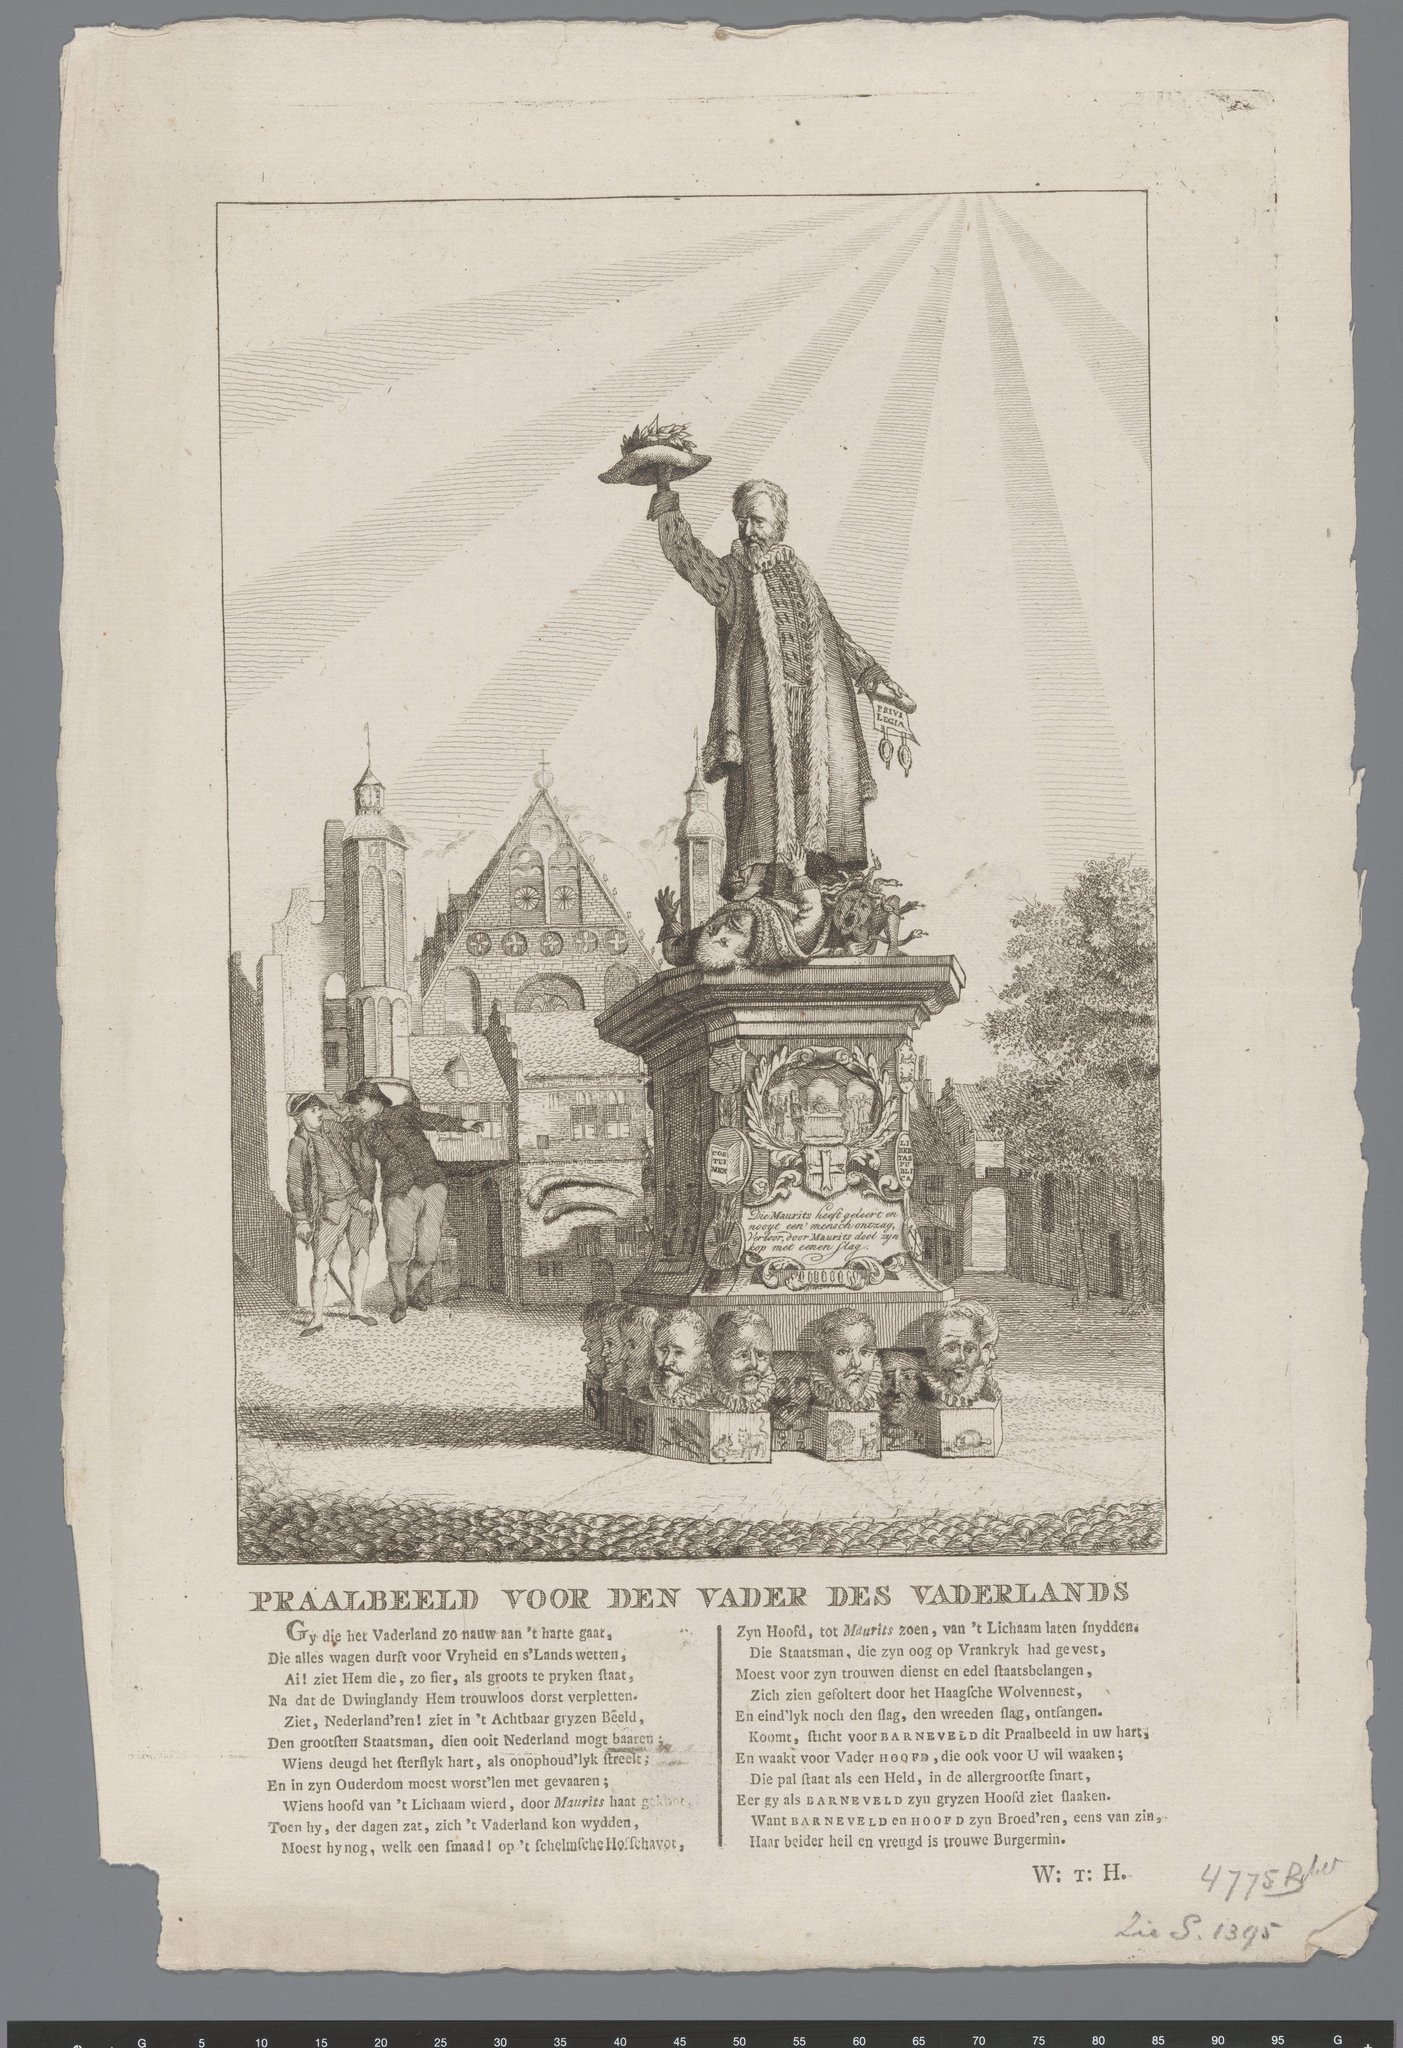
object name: print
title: Monument voor Johan van Oldenbarnevelt en Hendrik Danielsz. Hooft, 1787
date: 1787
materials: paper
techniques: engraving, etching, letterpress printing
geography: northern netherlands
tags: the hague, johan van oldenbarnevelt, amsterdam, hendrik danielsz. hooft, piece of sculpture, reproduction of a piece of sculpture, patriots (1780-1795)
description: Allegorisch standbeeld voor Johan van Oldenbarnevelt, gestorven 13 mei 1619. De landsadvocaat met vrijheidshoed en privilege in de hand, staande in triomf op prins Maurits en de personificatie van de Afgunst. Op het voetstuk een vers van vier regels, het beeld rustend op de hoofden van de 24 rechters die Van Oldenbarnevelt ter dood veroordeeld hebben met de hierbij corresponderende dieren. Op het grote plein van het Binnenhof. Op de achtergrond bespreken een boer en een heer, beiden patriotten, het standbeeld. Onder de voorstelling een vers in twee kolommen waarin Van Oldenbarnevelt vergeleken wordt met de Amsterdamse burgemeester Hendrik Danielsz. Hooft in zijn rol als verdediger van de belangen van de burgerij in 1787.